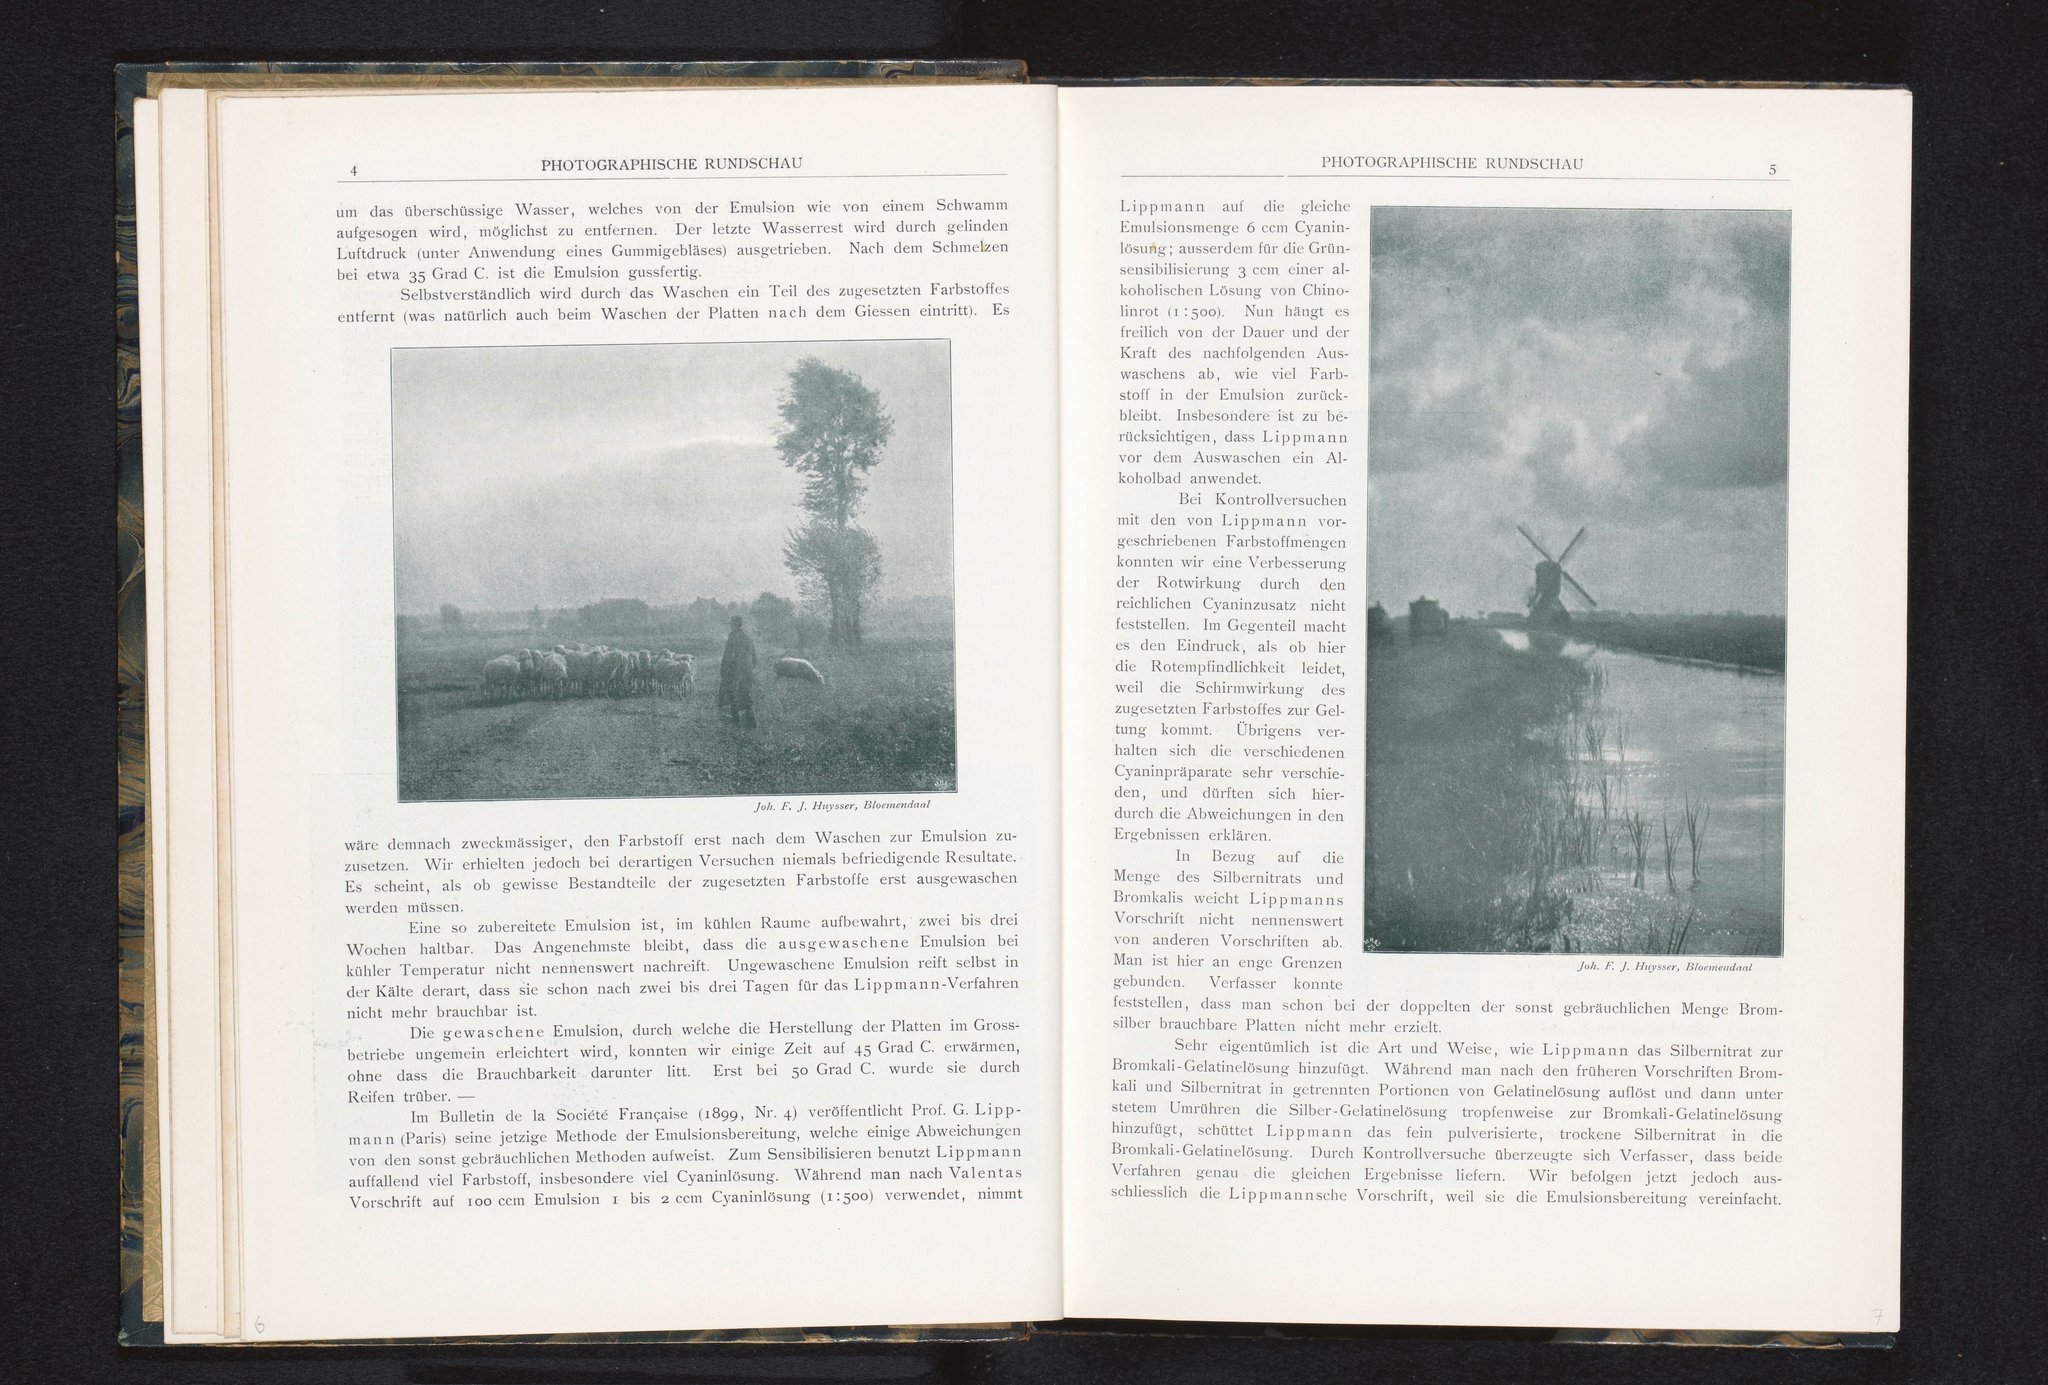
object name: photomechanical print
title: Gezicht op een weiland met schapen en een herder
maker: johan huijsser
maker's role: fotograaf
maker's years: 1868-1924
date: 1895-1900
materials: paper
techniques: autotype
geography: berlin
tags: herding, herdsman, herdswoman, shepherd, shepherdess, cowherd, etc., meadow, pasture, sheep